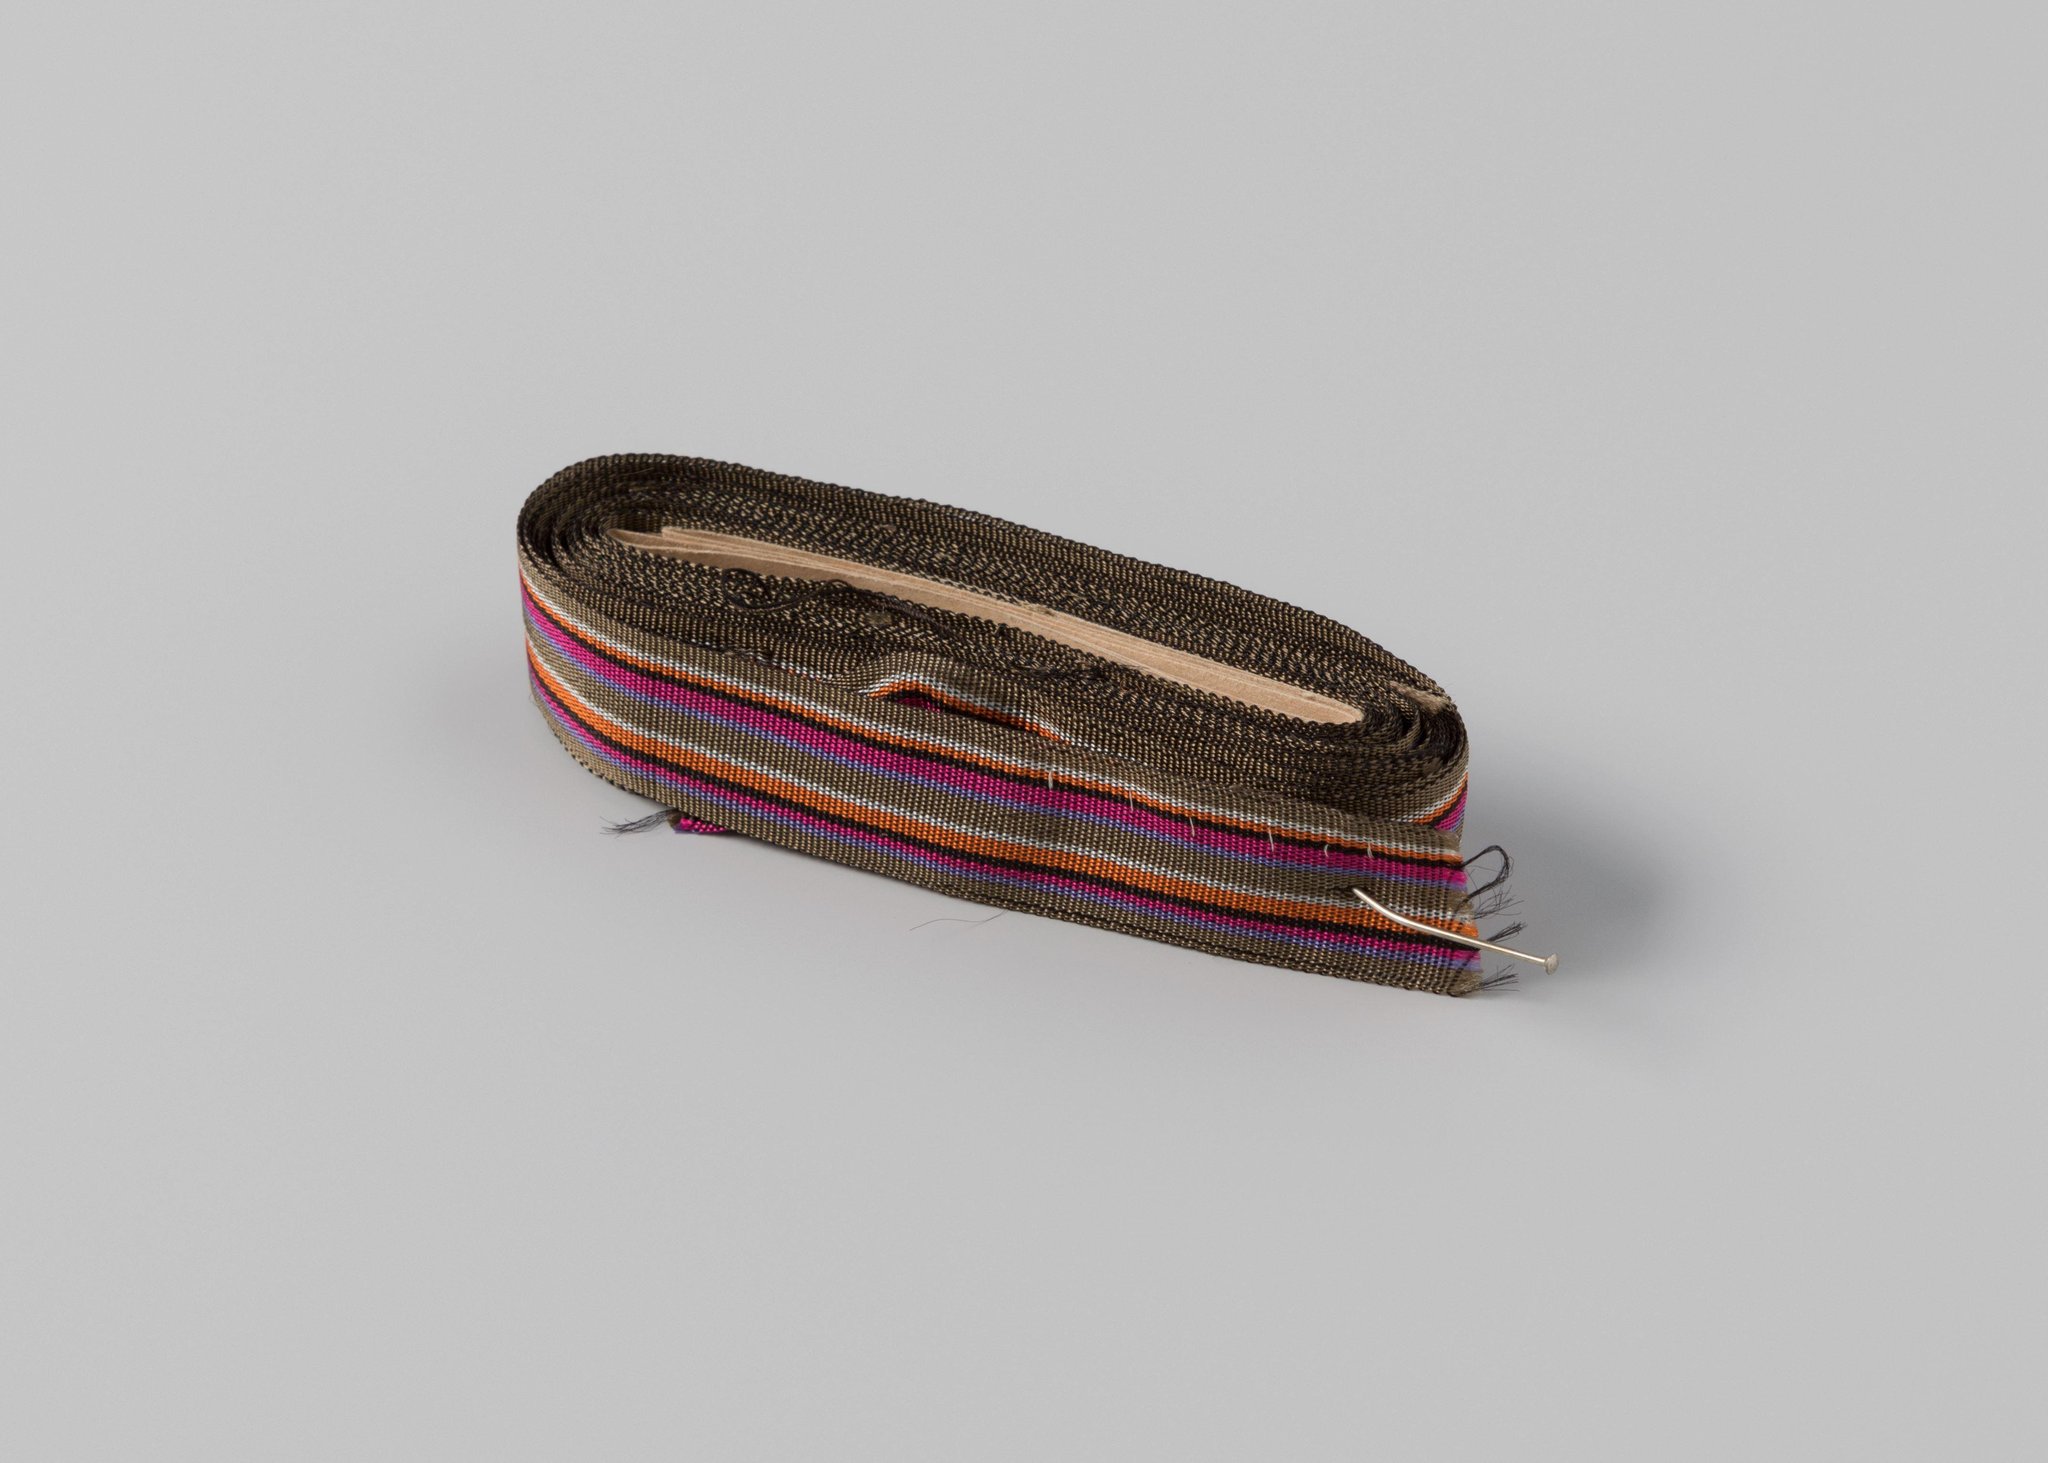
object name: braid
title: Lint, gestreept in legergroen, lichtblauw, oranje, zwart, fuchsia en lila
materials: paper, textile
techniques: weave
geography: nijmegen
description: Lint, gestreept in legergroen, lichtblauw, oranje, zwart, fuchsia en lila.